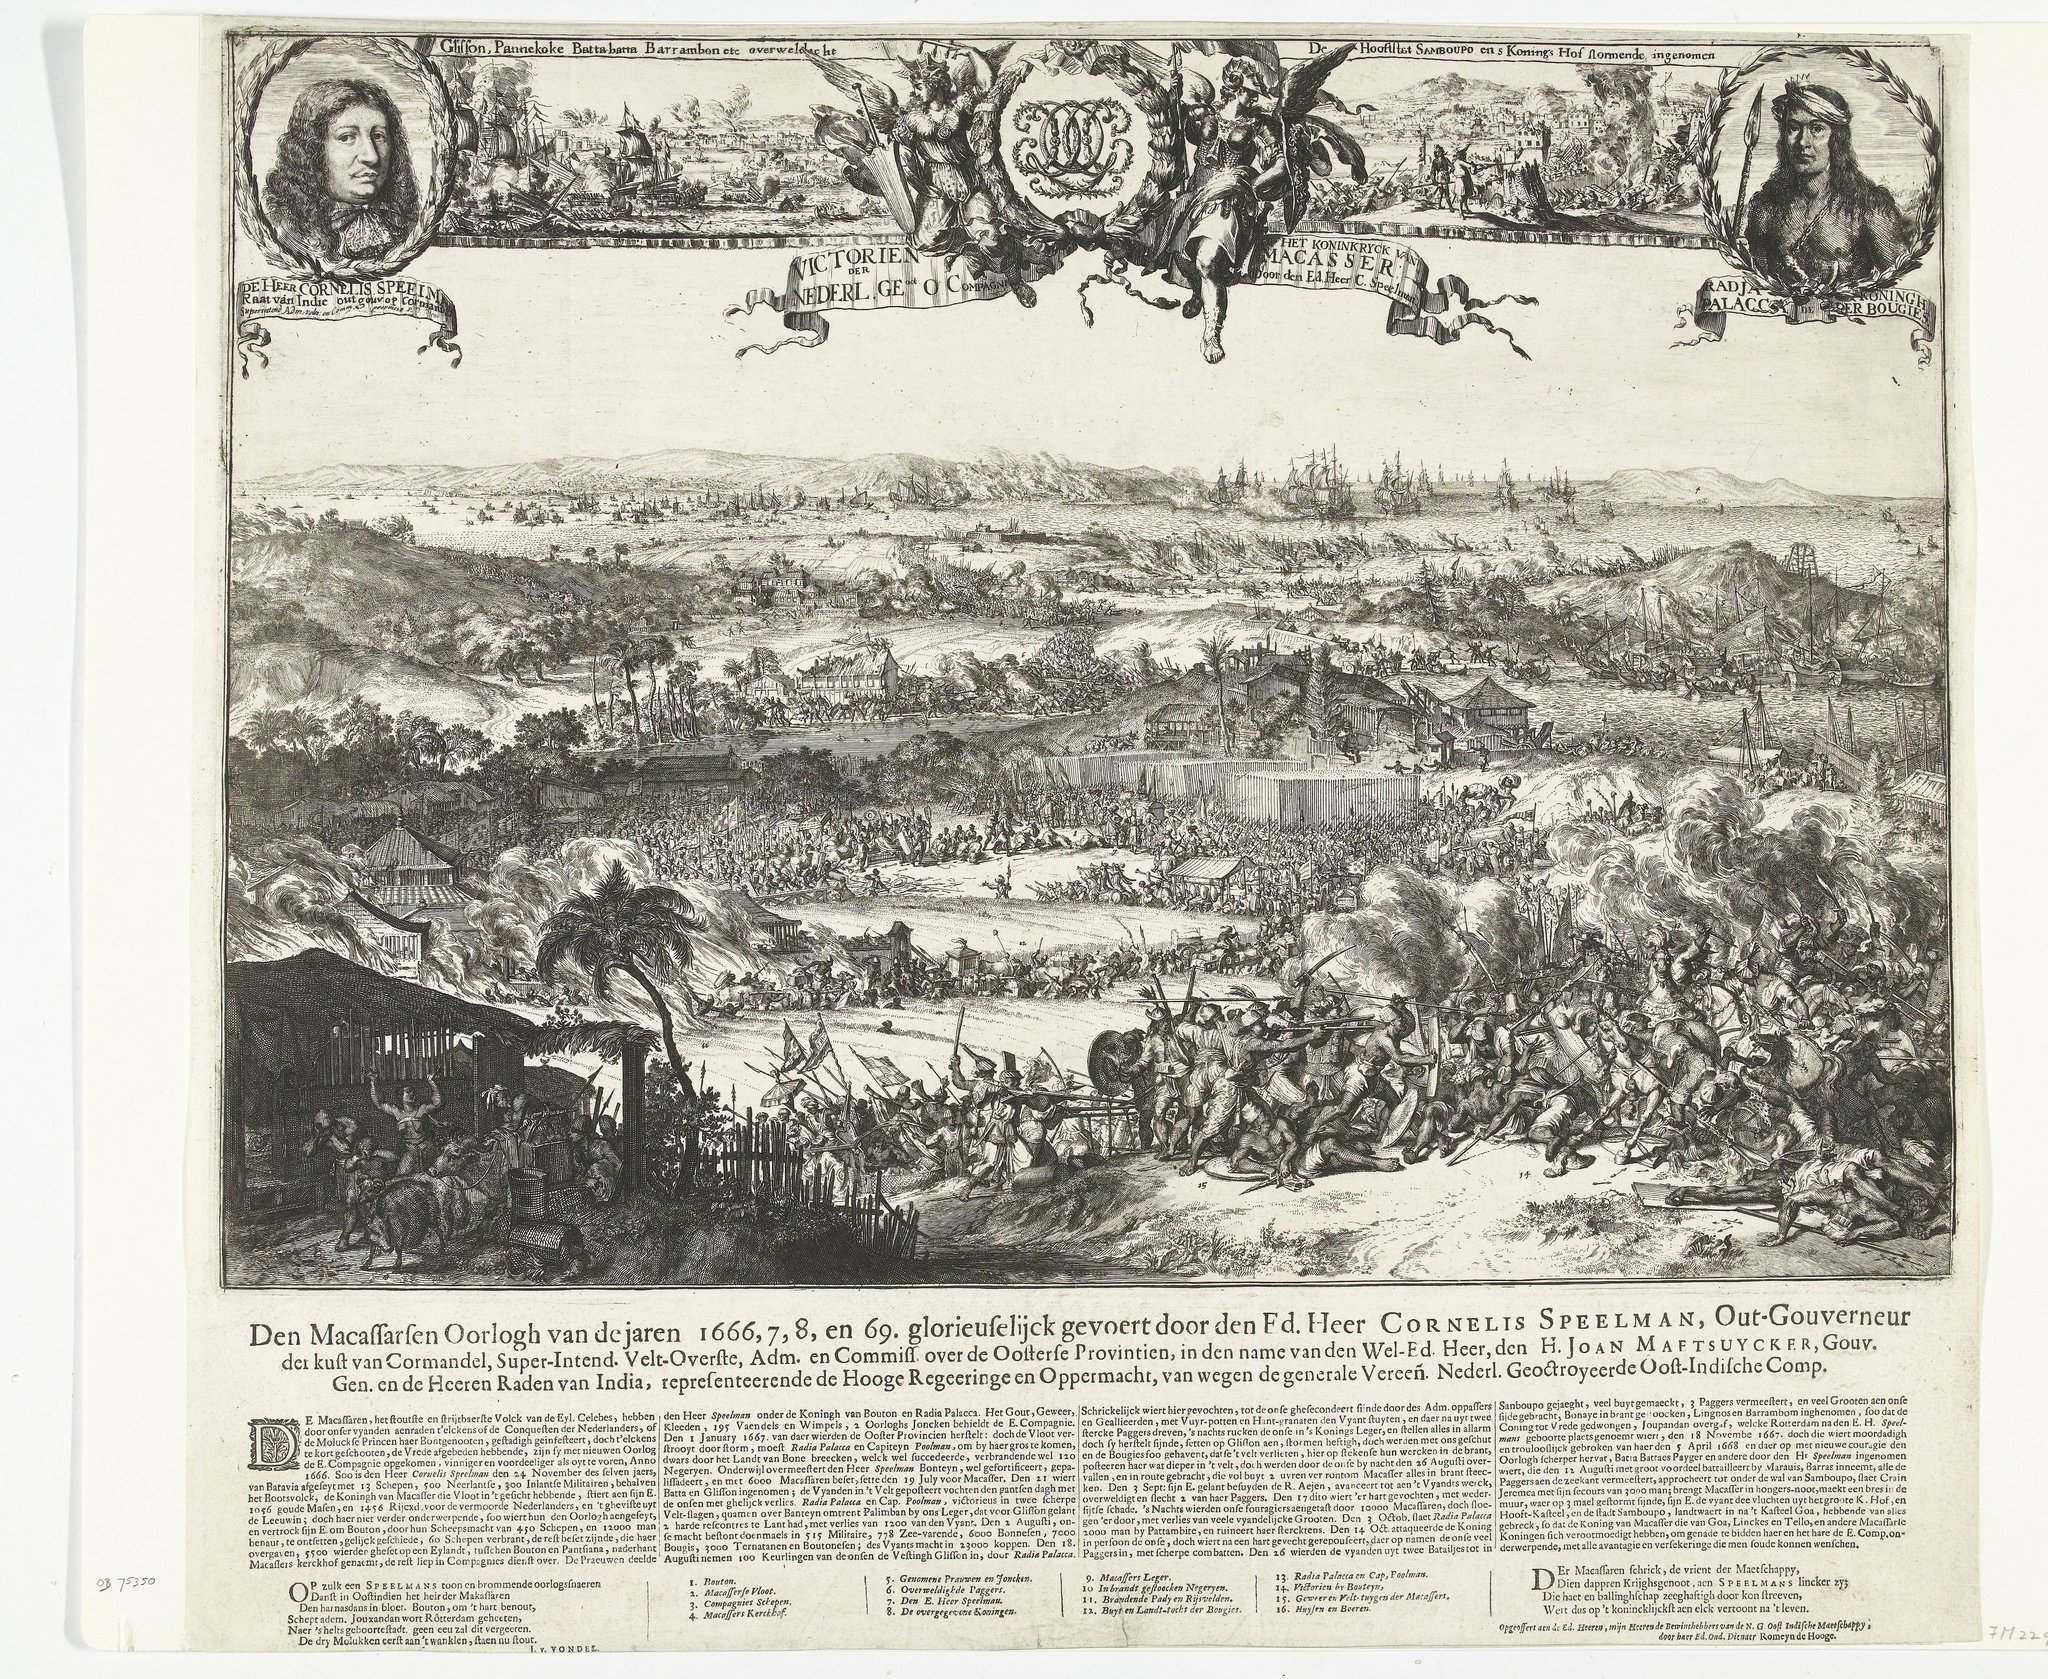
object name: print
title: Victorien der Nederl. Ge.oct. O. Compagn. op het Koninkryck van Macasser door den Ed. Heer C. Speelman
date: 1670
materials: paper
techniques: etching, letterpress printing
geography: northern netherlands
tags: rotterdam, batavia, battle, fighting in general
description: Overwinningen van Cornelis Speelman op het koninkrijk Makassar, 1666-1669. Gedetailleerd beeld van het landschap van Makassar met alle gevechten die daar in de jaren 1666, 1667, 1668 en 1669 gevoerd zijn door de oud-gouverneur Cornelis Speelman namens de VOC. Bovenaan de portretten van Speelman en van Radja Palacca, koning der Bougies. Onder de plaat een tekst in 4 kolommen met een chronologische beschrijving van het verloop van de gebeurtenissen, een vers van Vondel van 6 regels, de opdracht van De Hooghe van deze plaat aan de bewindhebbers van de VOC en de legenda 1-16.